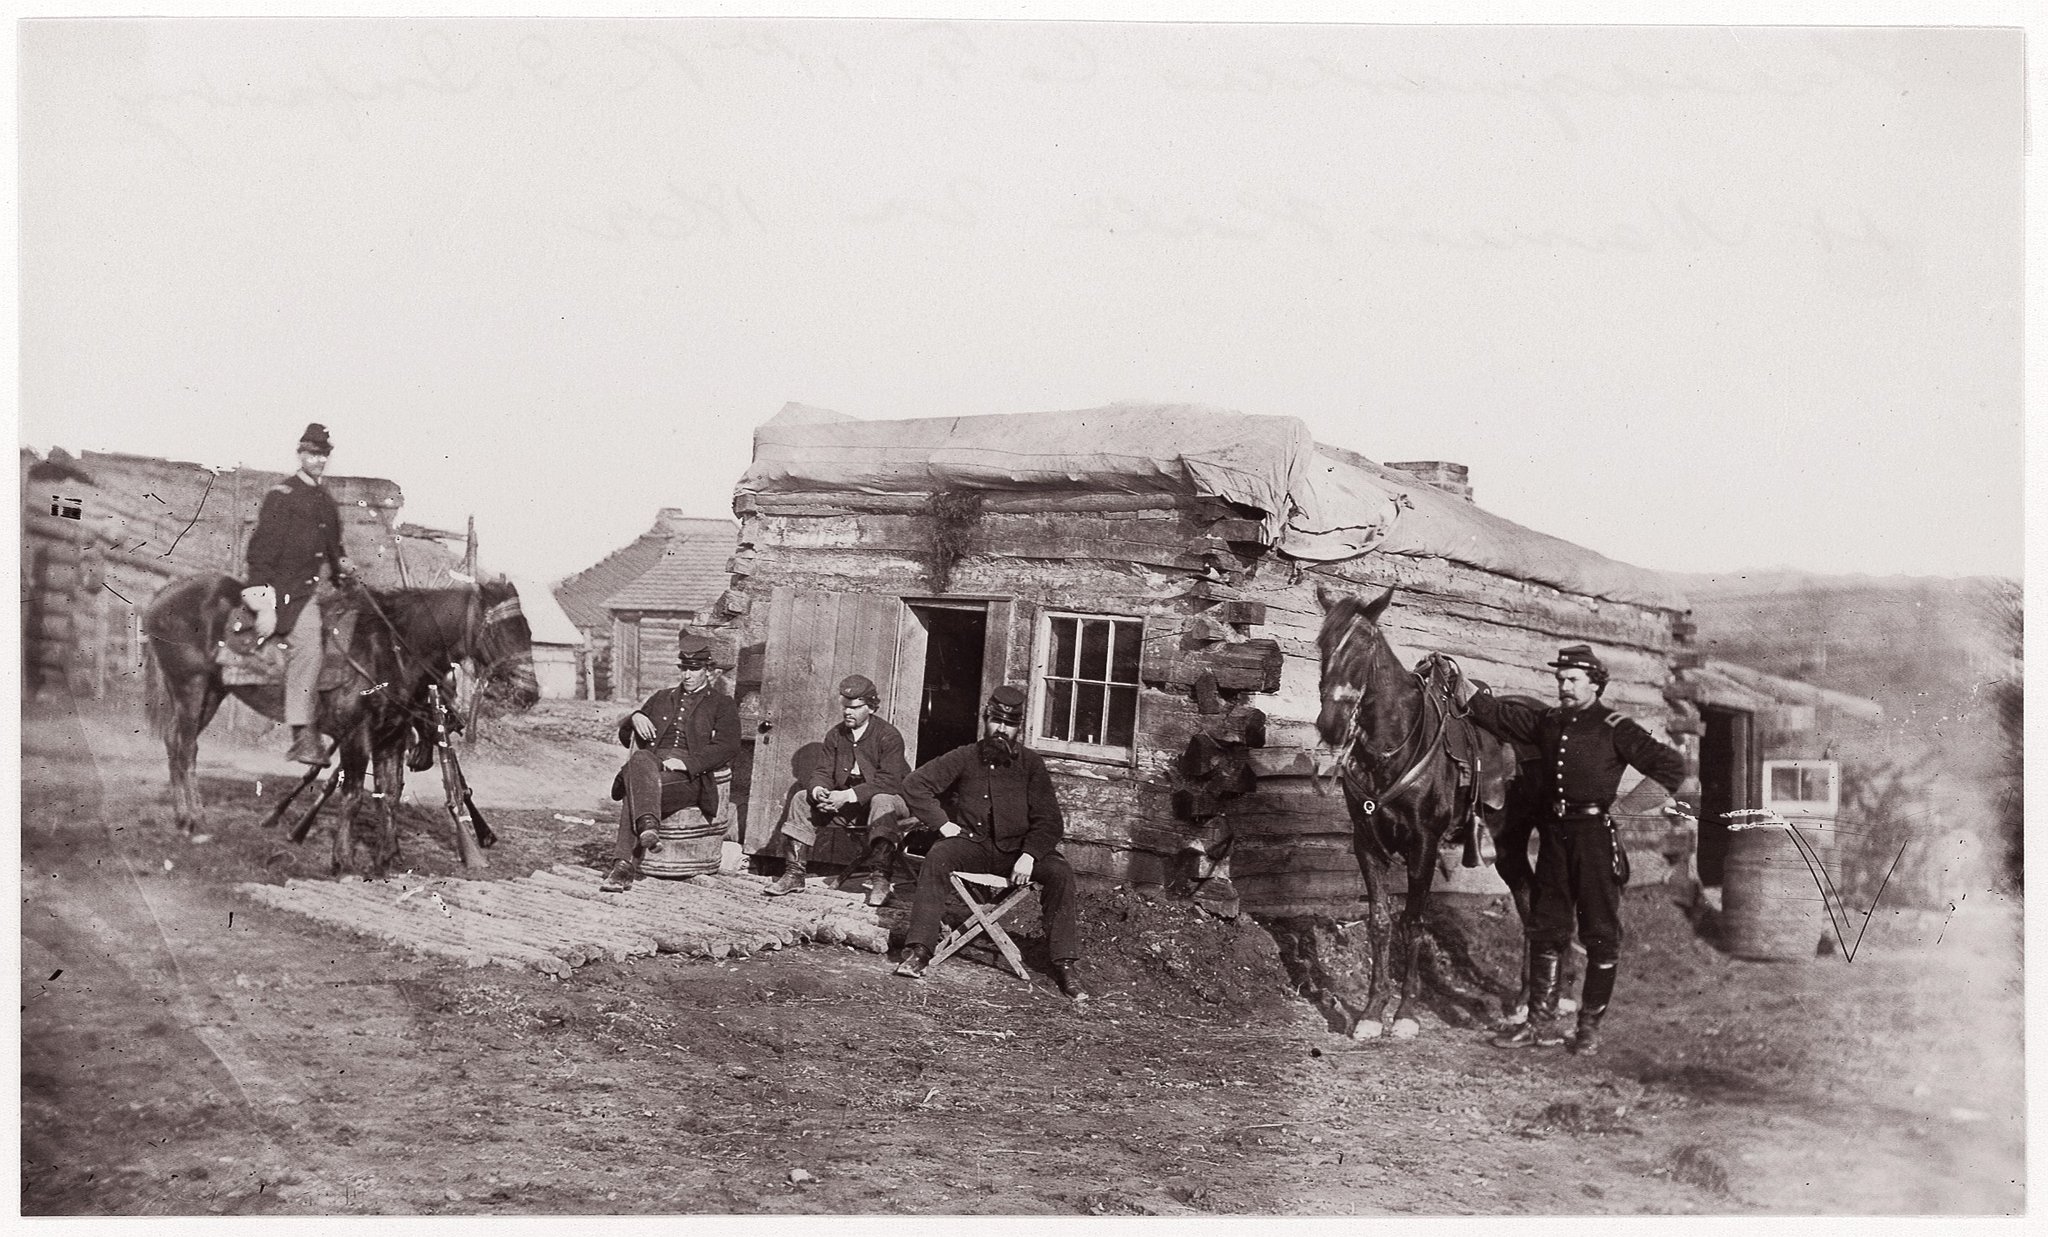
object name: photograph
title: Headquarters, Co. F, 11th Rhode Island Infantry, Miner's Hill, Virginia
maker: Anonymous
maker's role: artist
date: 1862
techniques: albumen silver print, glass negative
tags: army,soldiers,american civil war,horses